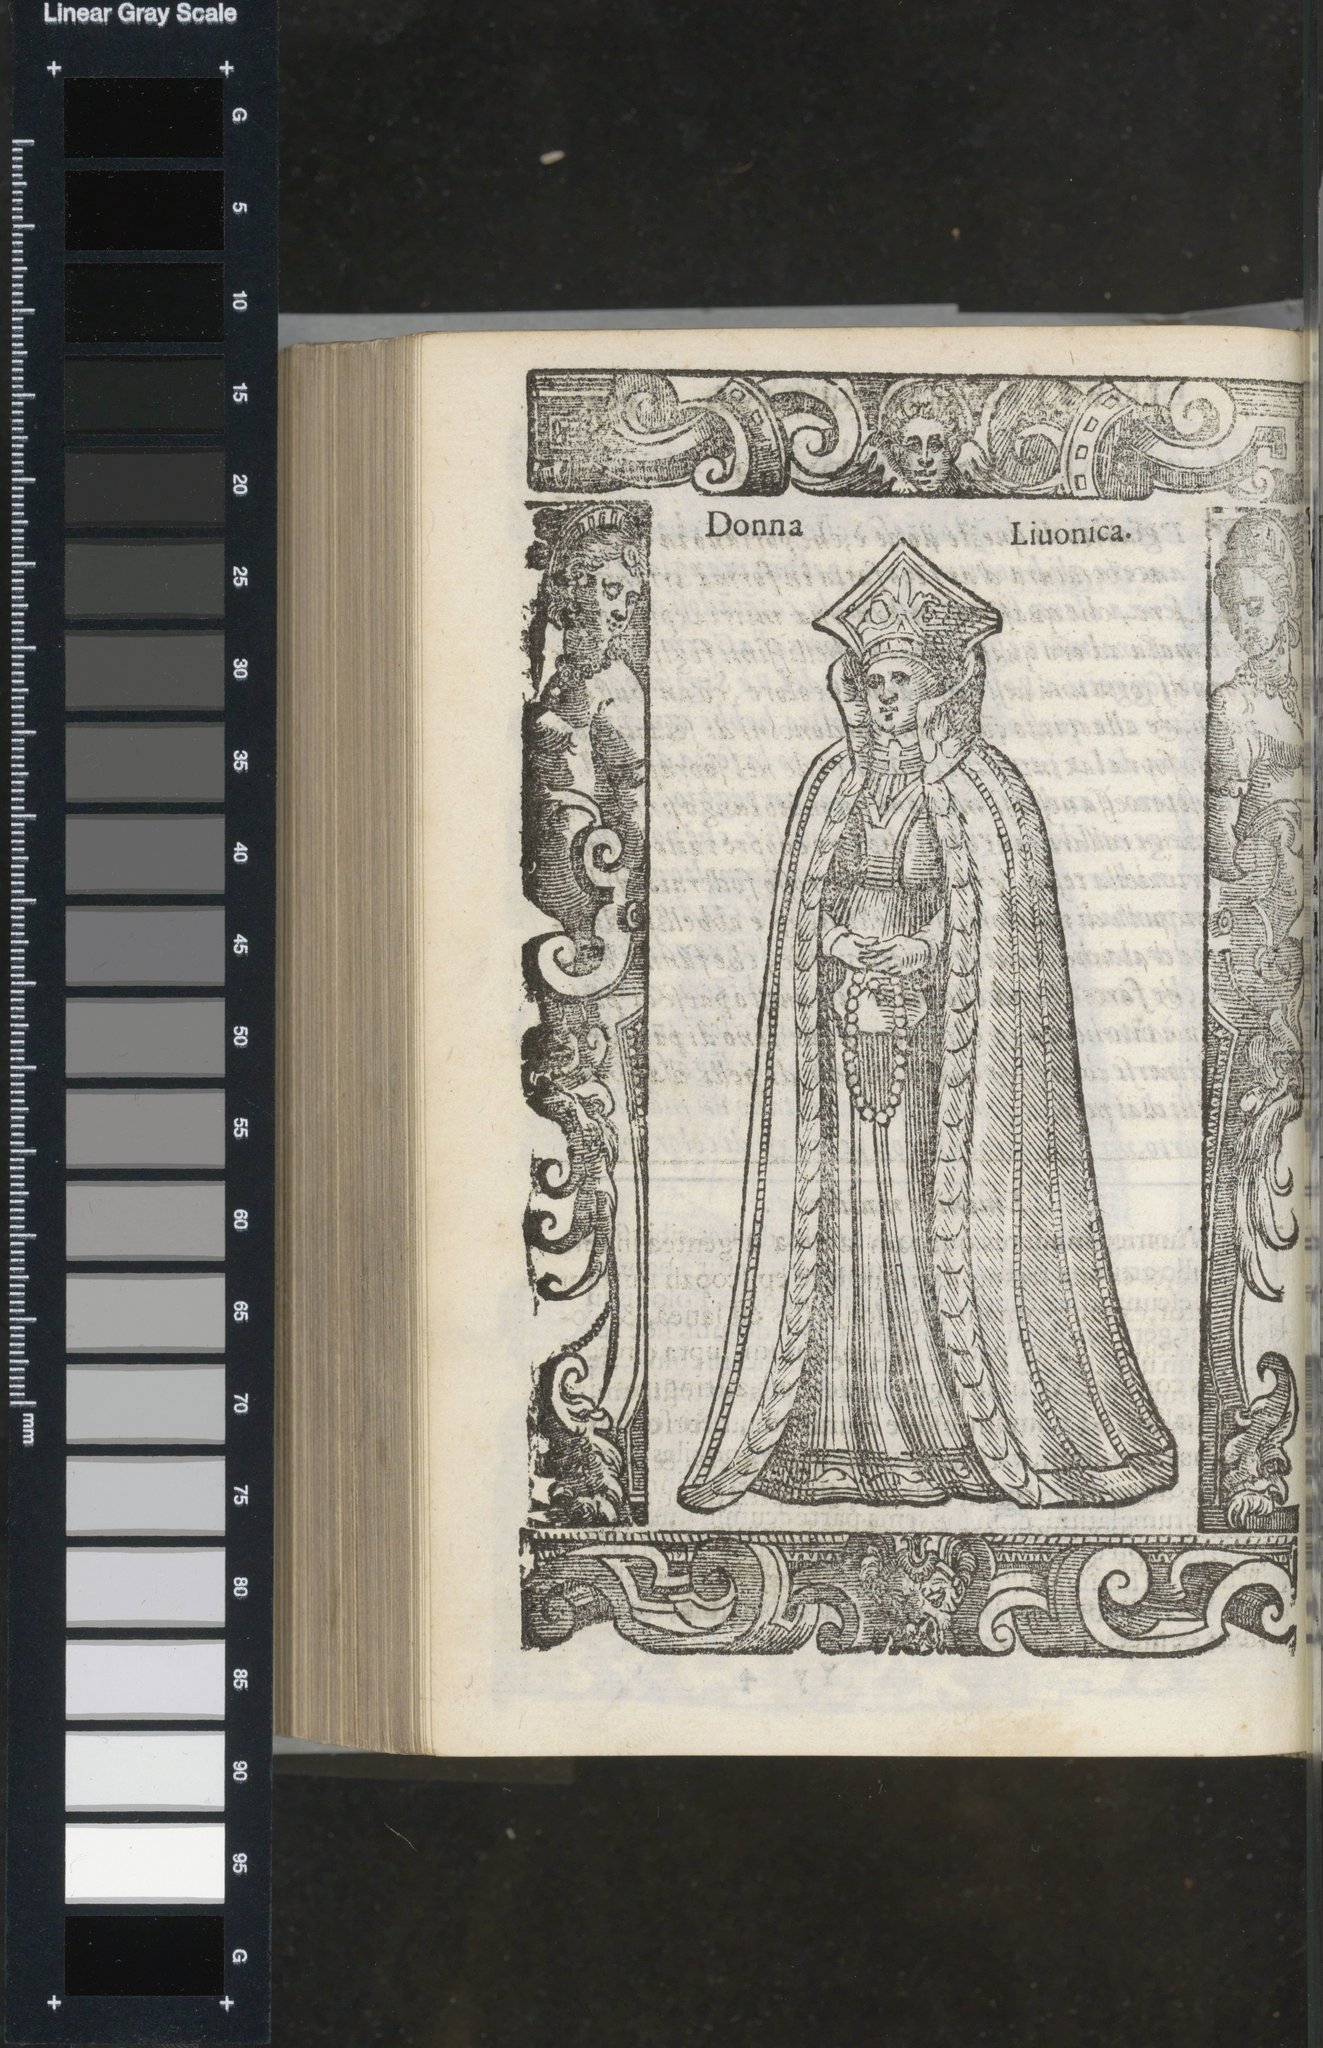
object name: costume print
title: Habiti antichi, et moderni di tutto il mondo...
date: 1598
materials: paper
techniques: woodcut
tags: fashion plates